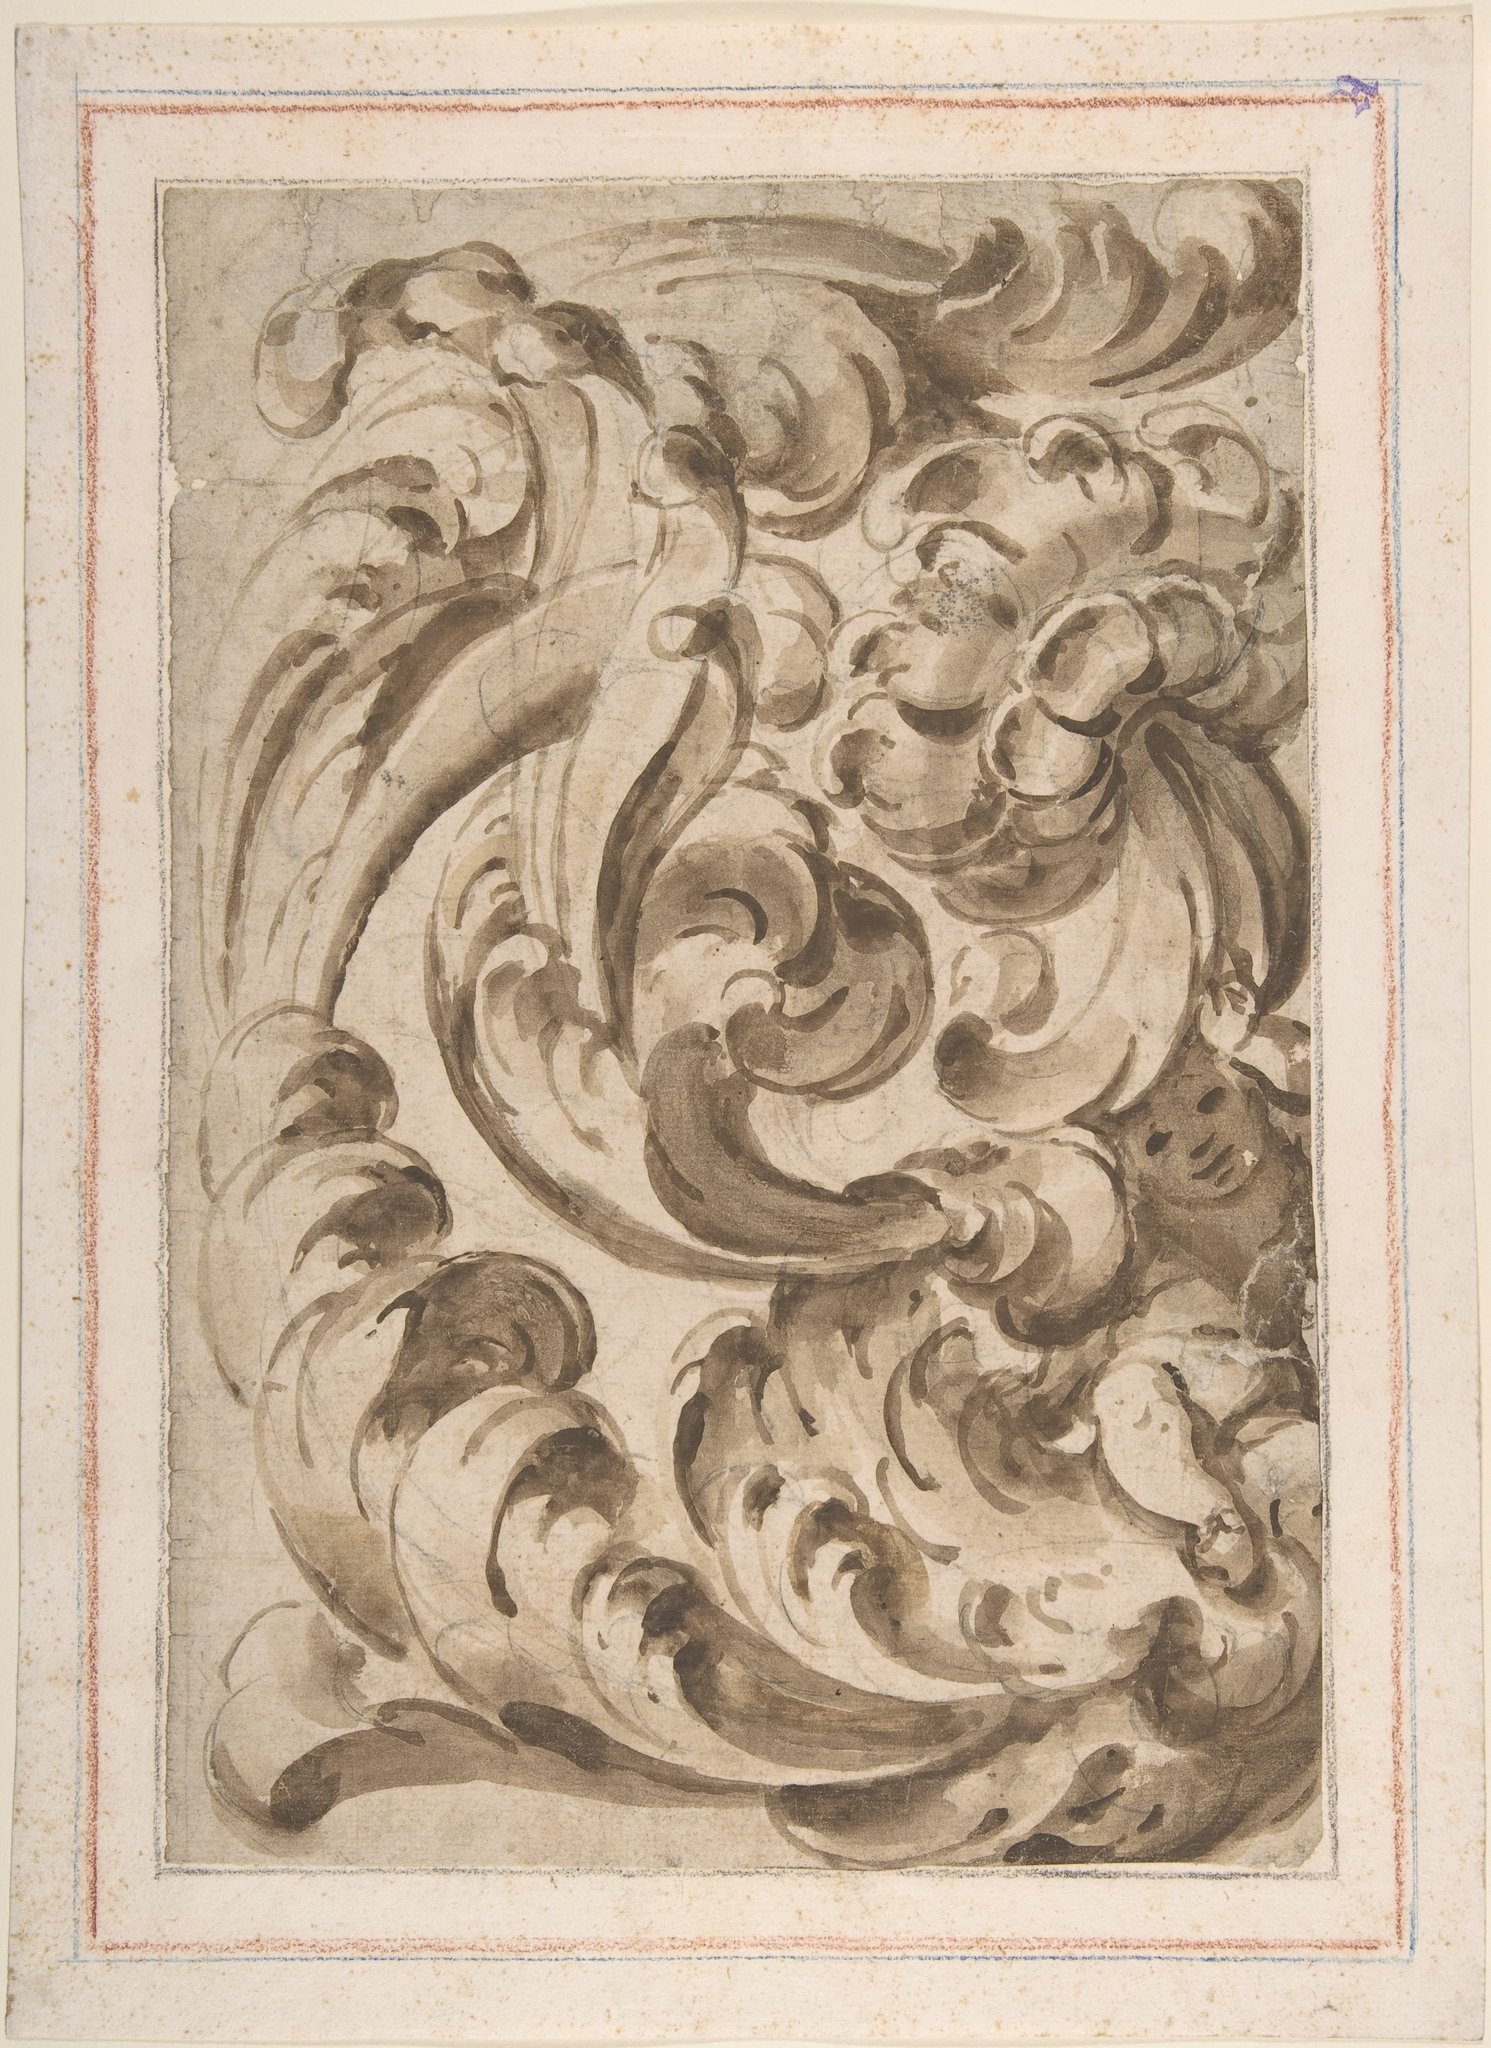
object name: drawing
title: Overall Pattern of Acanthus Scrolls with a Putto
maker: anonymous, italian, 17th century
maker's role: artist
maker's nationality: italian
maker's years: 1600-1700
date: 1601-1700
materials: graphite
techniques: brush, wash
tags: acanthus